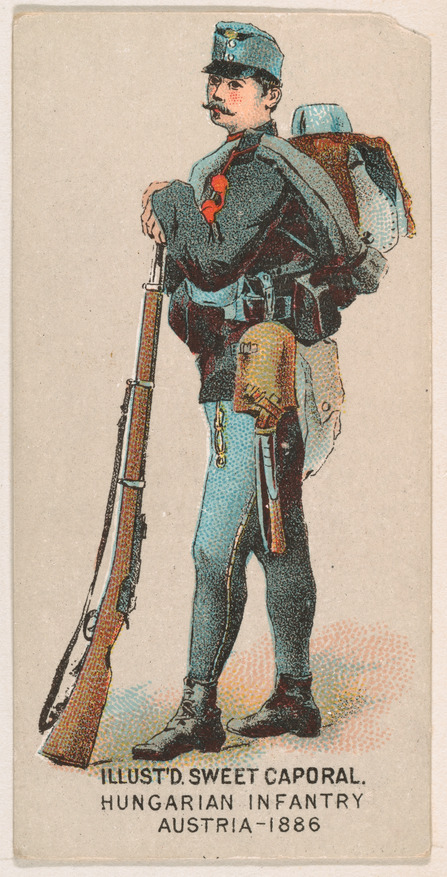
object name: print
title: Hungarian Infantry, Austria, 1886, from the Military Series (N224) issued by Kinney Tobacco Company to promote Sweet Caporal Cigarettes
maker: kinney brothers tobacco company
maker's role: publisher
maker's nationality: american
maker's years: 1869-2011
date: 1888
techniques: color lithograph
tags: military,firearms,men